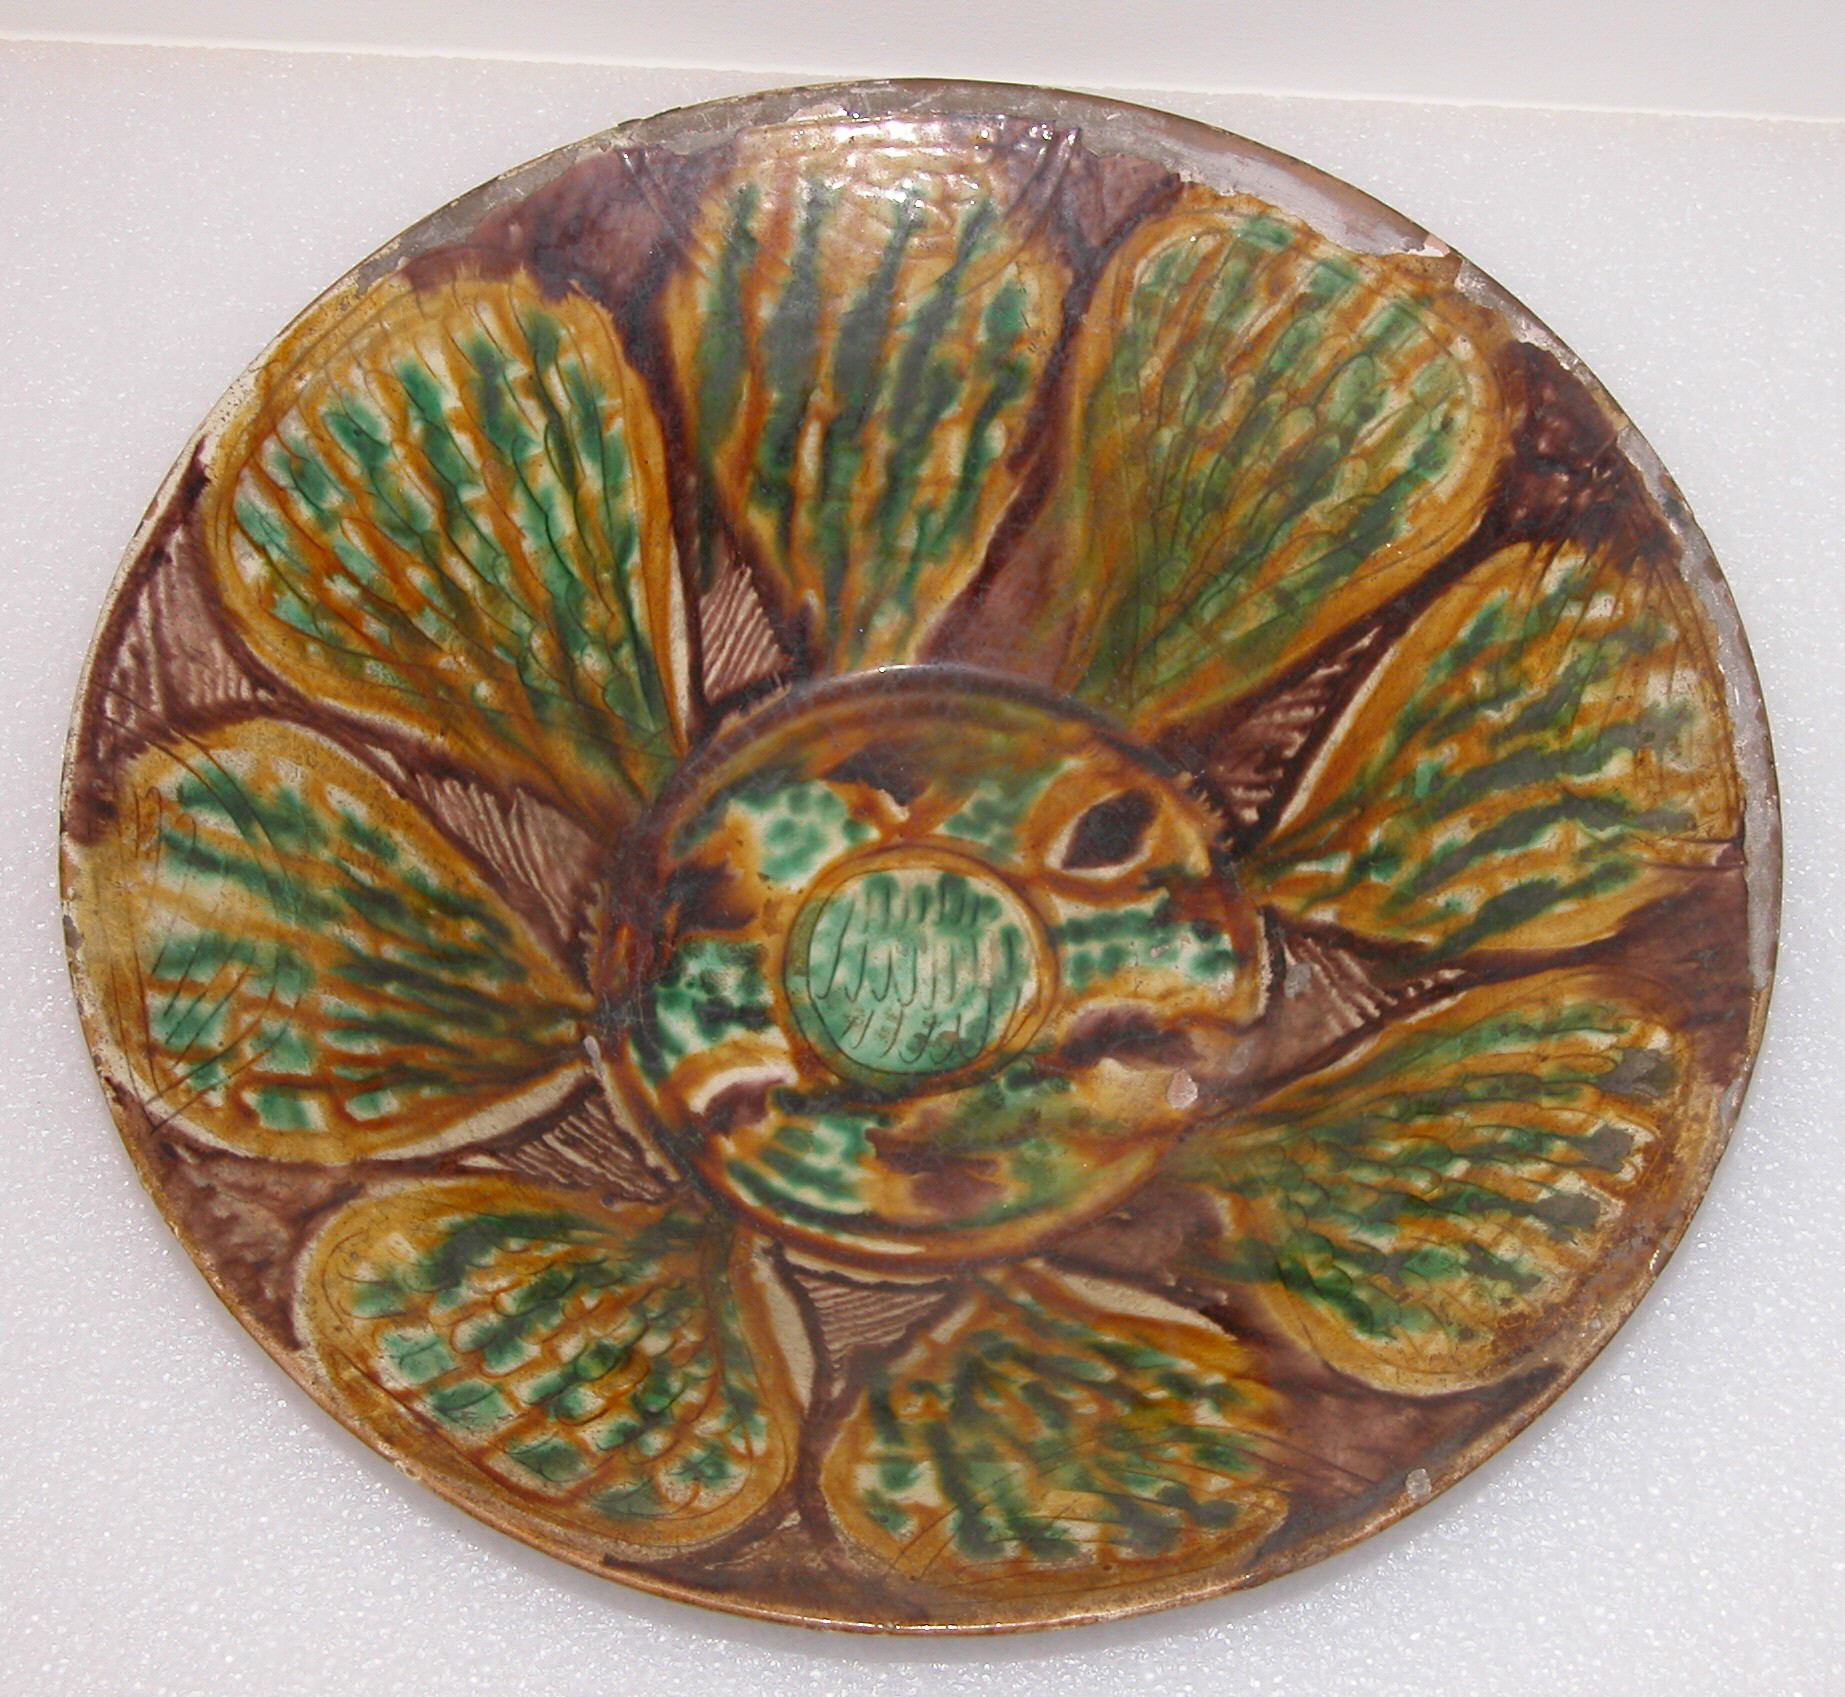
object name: bowl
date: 901-1000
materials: earthenware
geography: uzbekistan